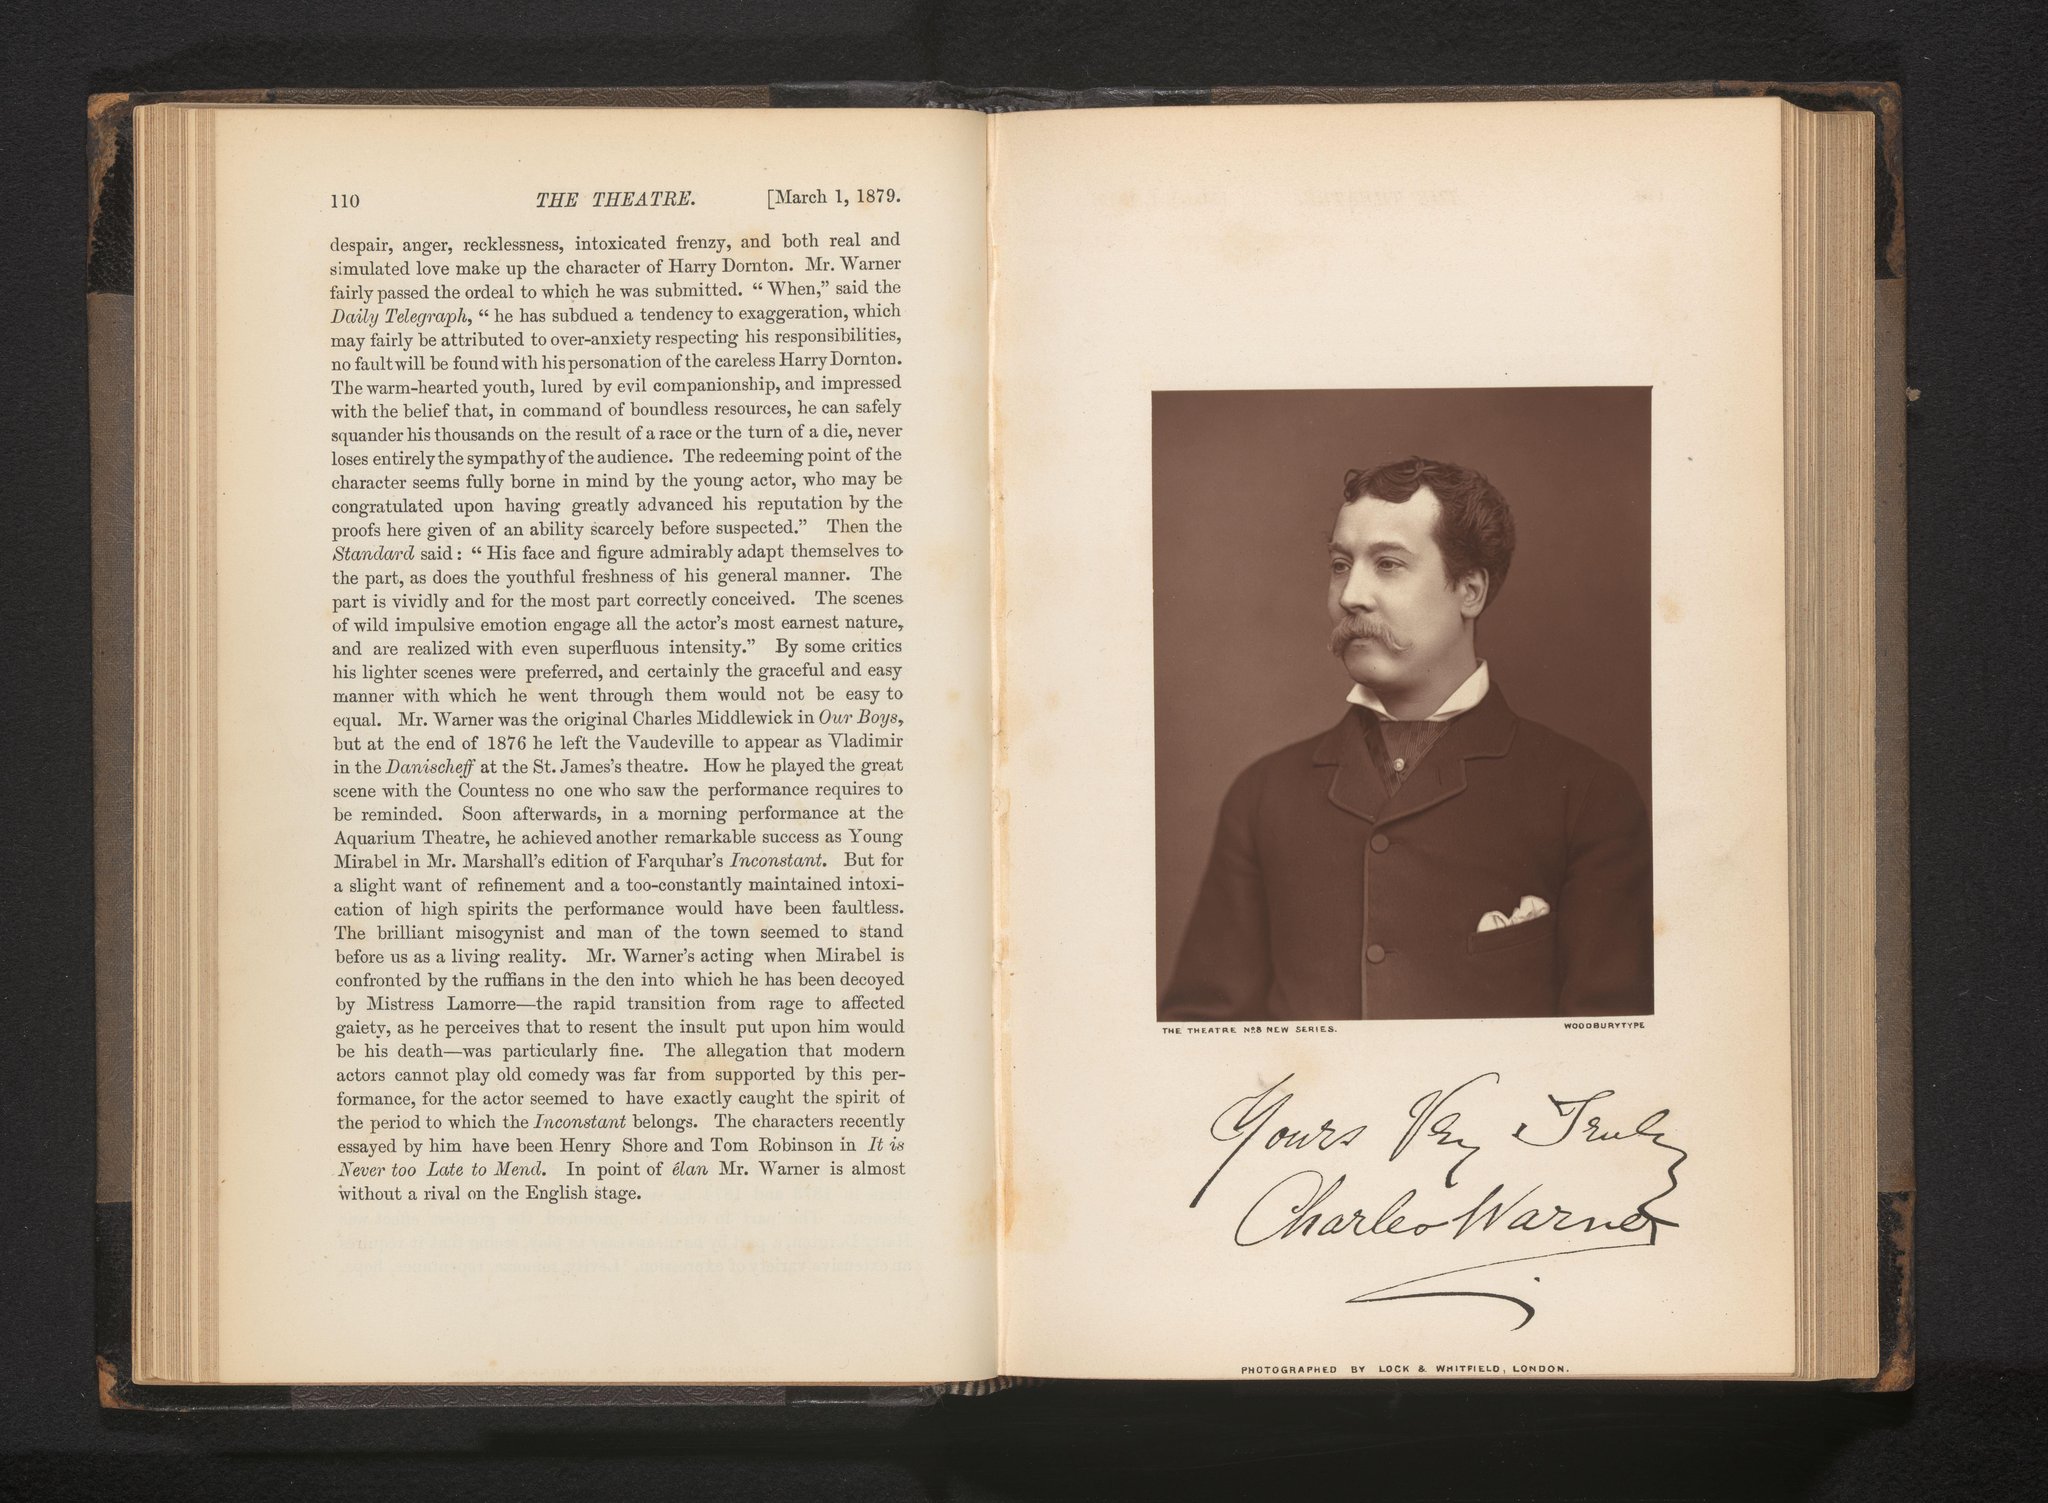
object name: page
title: Portret van Mr Warner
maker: Anonymous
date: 1874-1879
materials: paper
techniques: woodburytype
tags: adult man, historical persons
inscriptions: signature: ‘[...]/ Chares Warner’